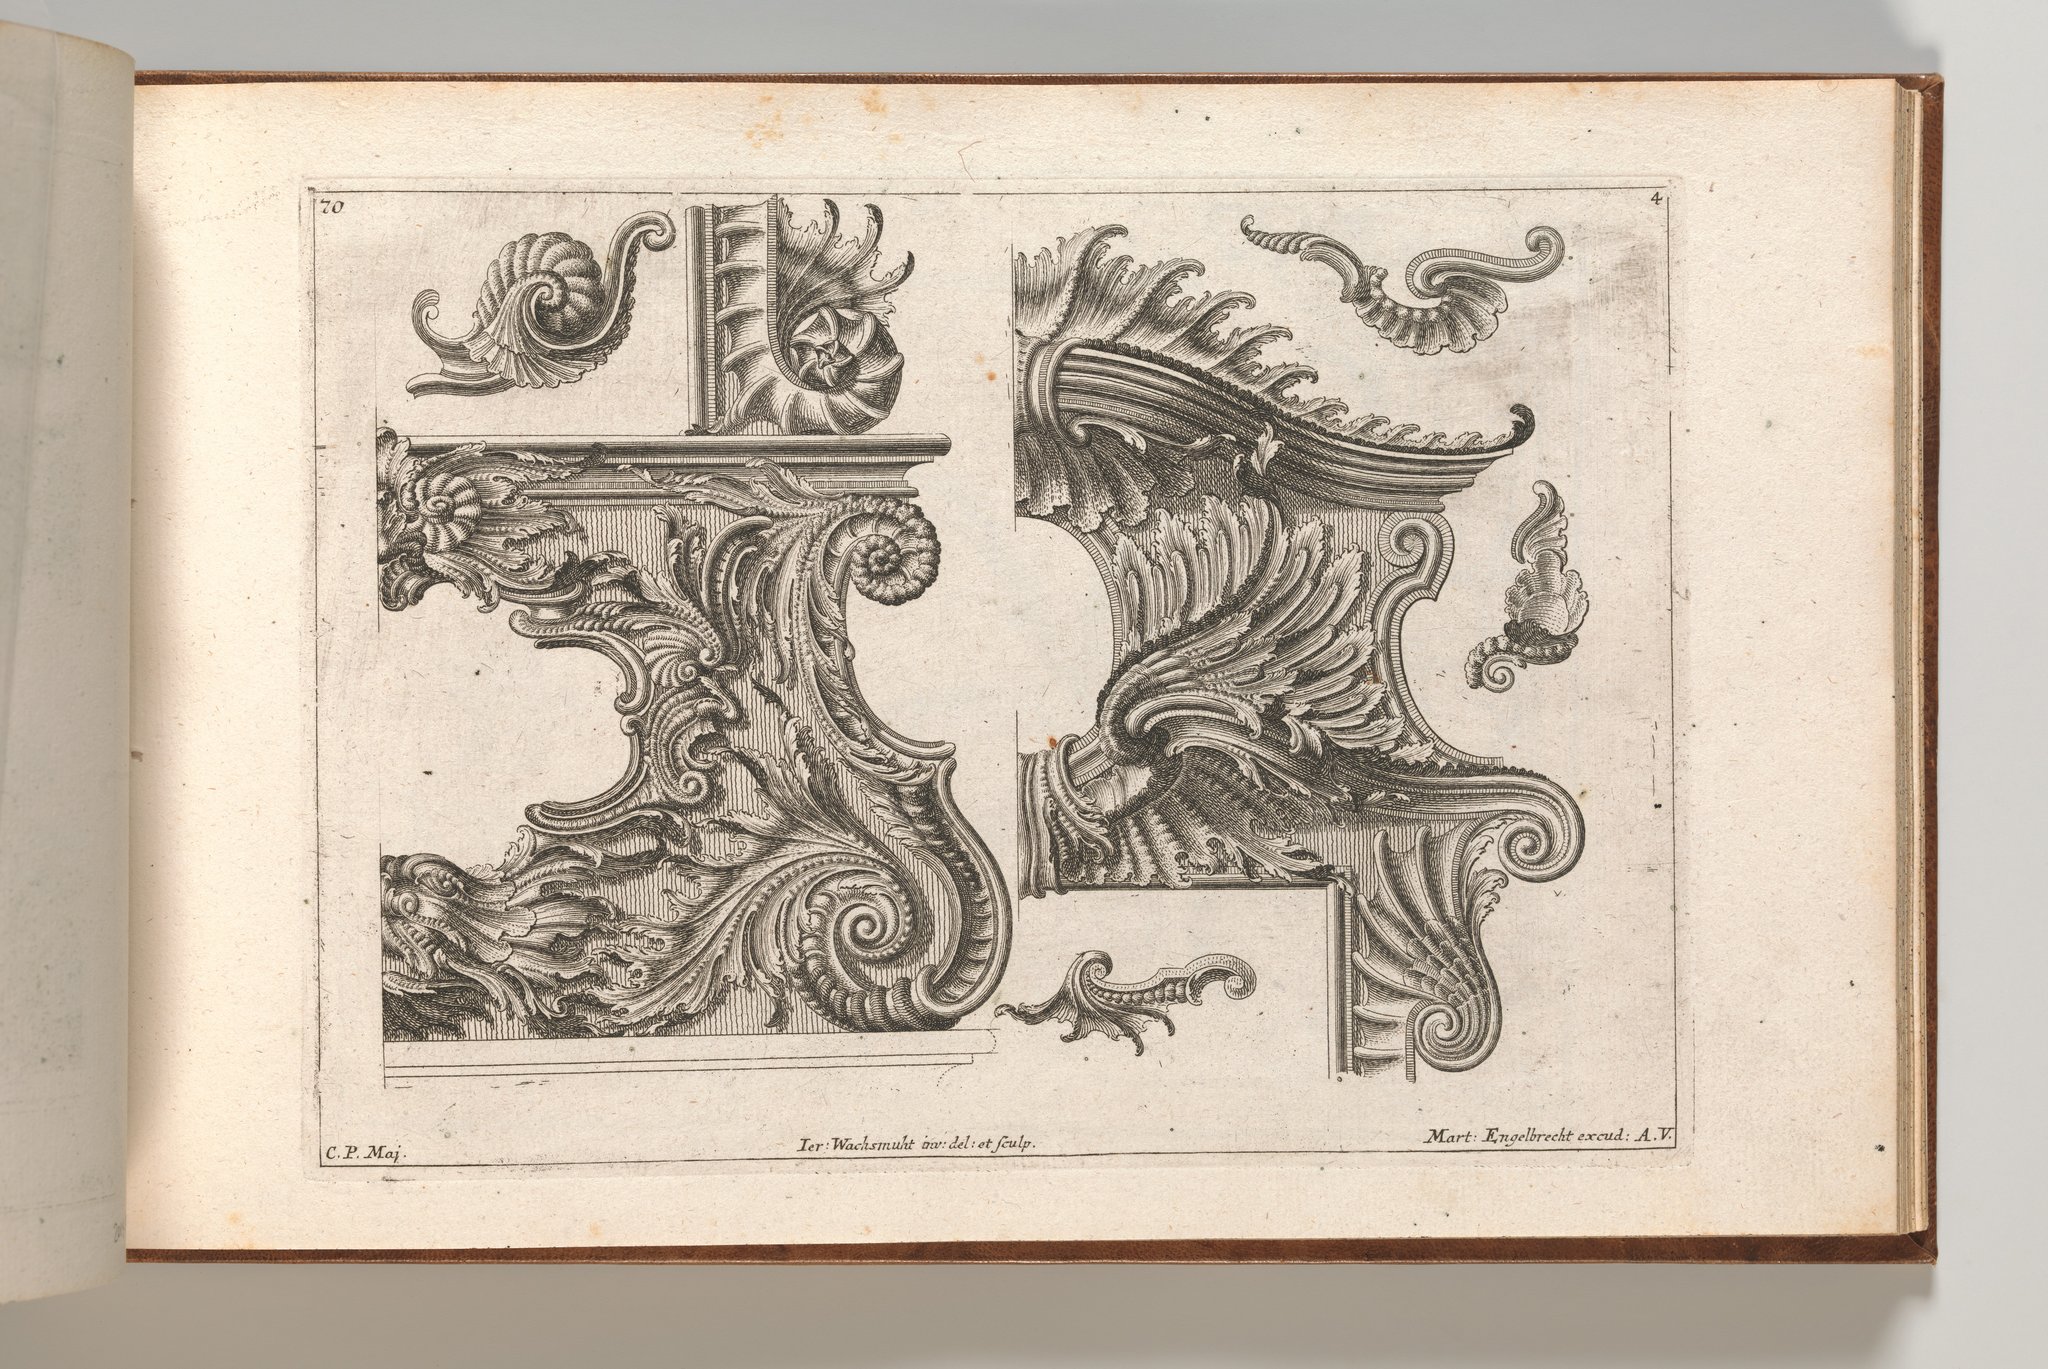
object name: album print ornament architecture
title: Suggestion for the Decoration of the Lower and Top Right of a Frame, Plate 4 from: 'Unterschidliche Auszierungen zu Thüren und Fenster, etc. etc. sehr nutzlich zu gebrauchen'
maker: jeremias wachsmuth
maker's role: artist and engraver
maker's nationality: german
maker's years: 1712-1771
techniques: etching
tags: ornament